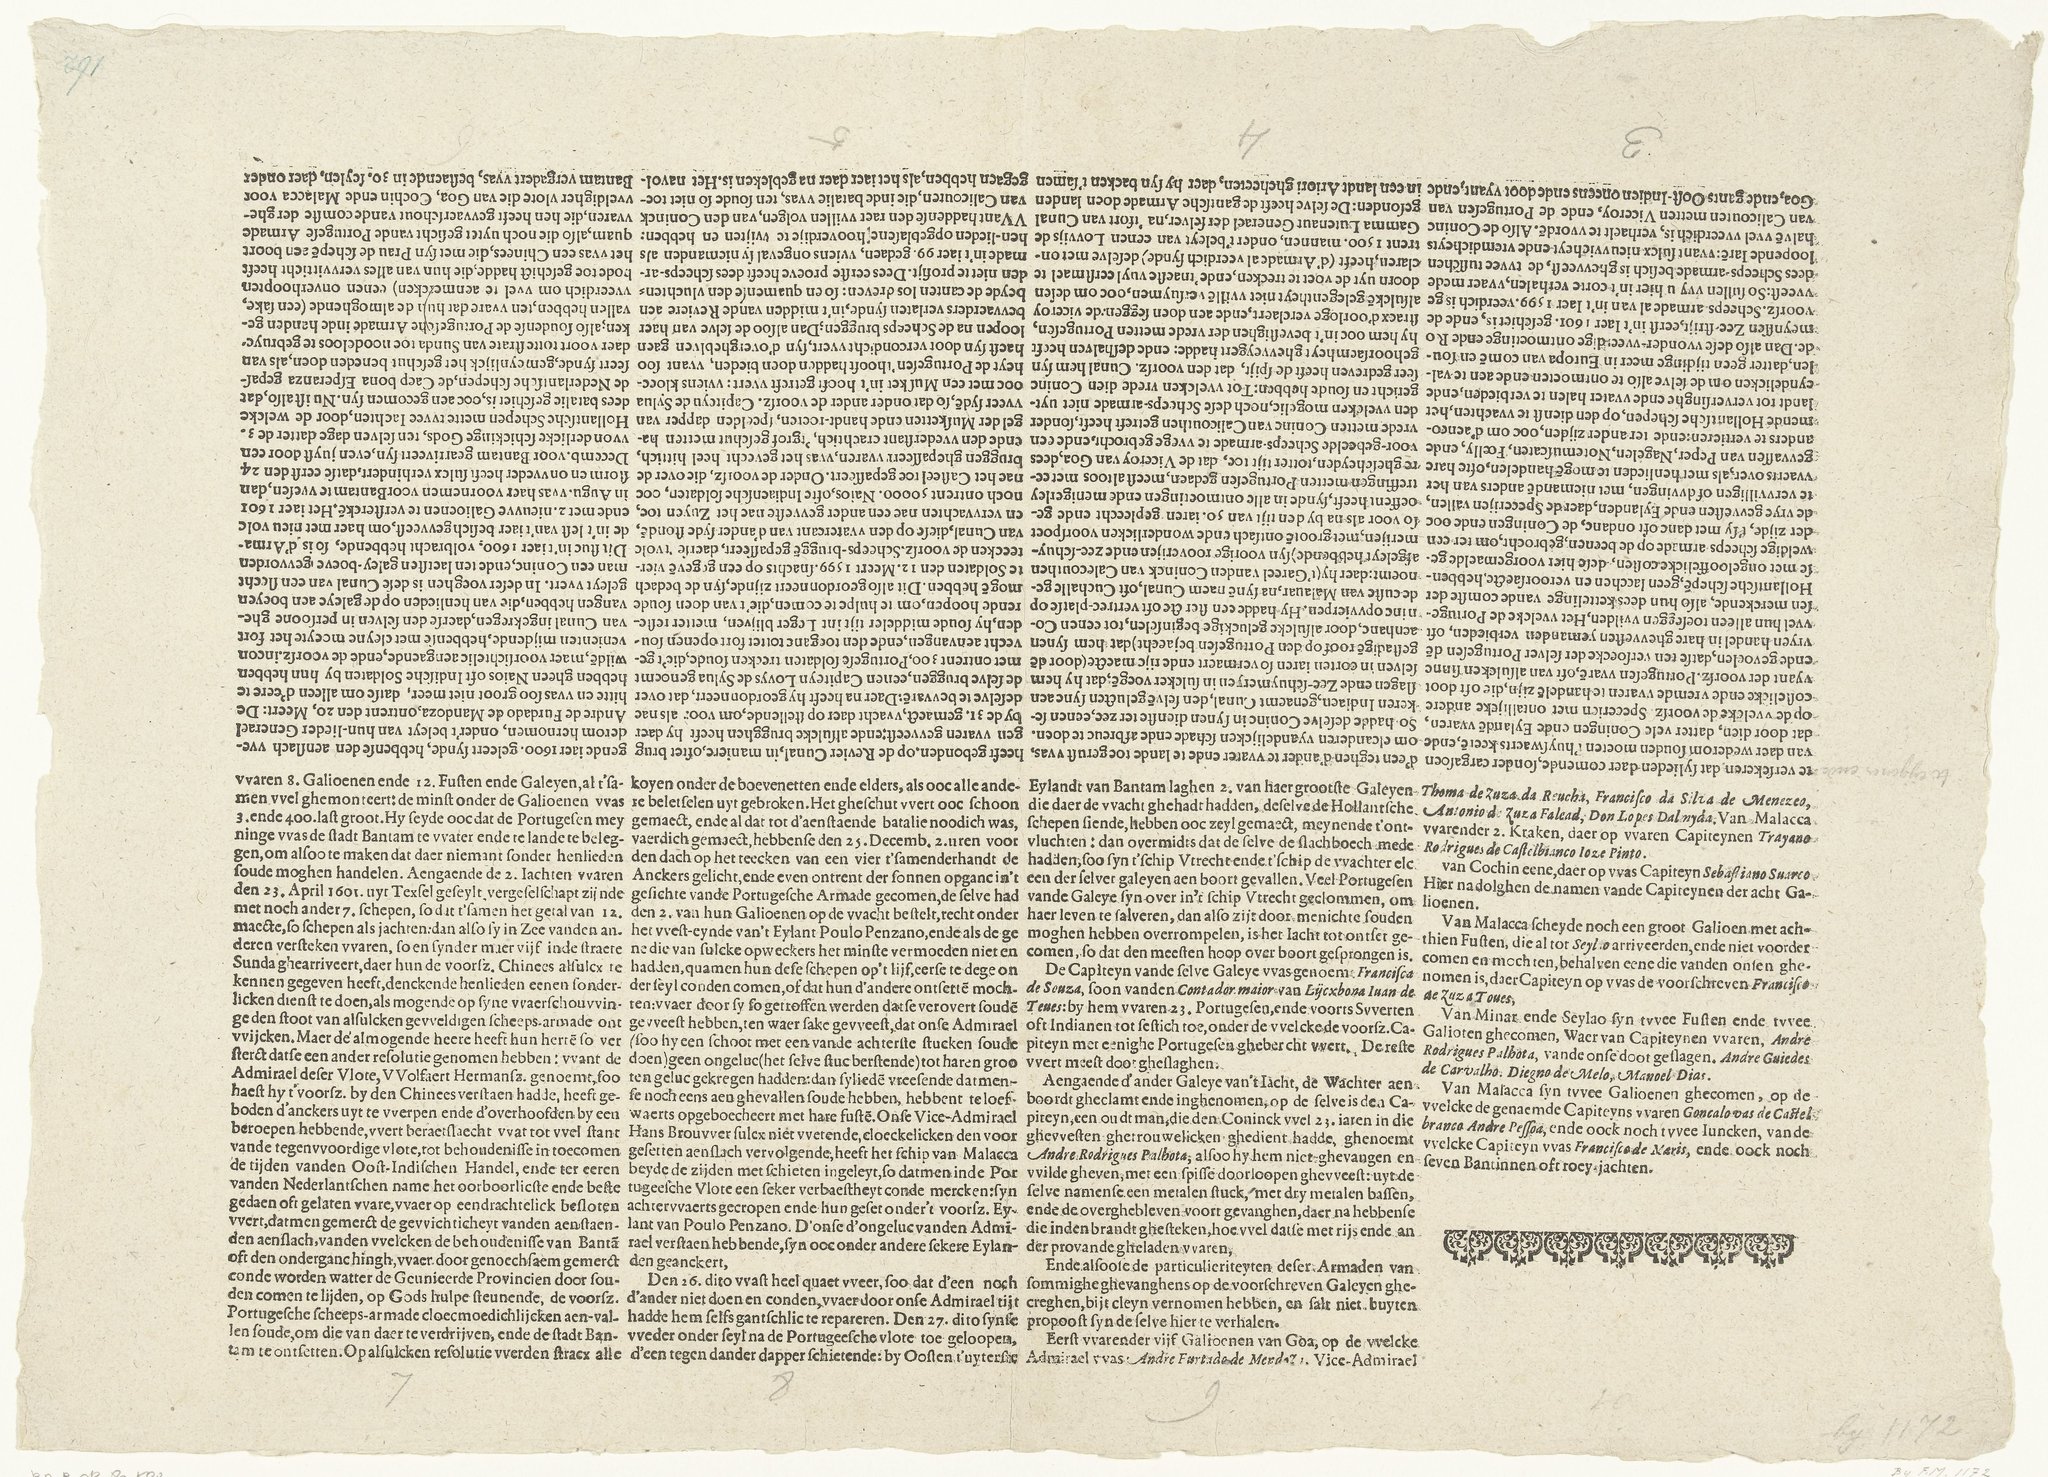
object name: print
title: Warachtighe Afbeeldinghe vanden wonderbaren ende ghedenckwaerdighen Scheeps-strijdt ende slagh / welcke in Oost-Indien / int ghesichte van de vermaerde Coopstadt Bantam gheschiet is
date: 1603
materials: paper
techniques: letterpress printing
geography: amsterdam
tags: verenigde oostindische compagnie, admiraal, hermansz, wolfert, bantam, zeeslag voor bantam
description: Tekstblad met het middenstuk van de beschrijving van de overwinning van de admiraal Wolfert Hermansz met vijf schepen op de Portugese vloot van dertig schepen in de zeeslag voor Bantam, 25-30 december 1601. Grote voorstelling op drie bladen met bijbehorende tekstbladen. Tekstblad met 2 keer 4 kolommen van de beschrijving, bedoeld om los te knippen en te monteren.